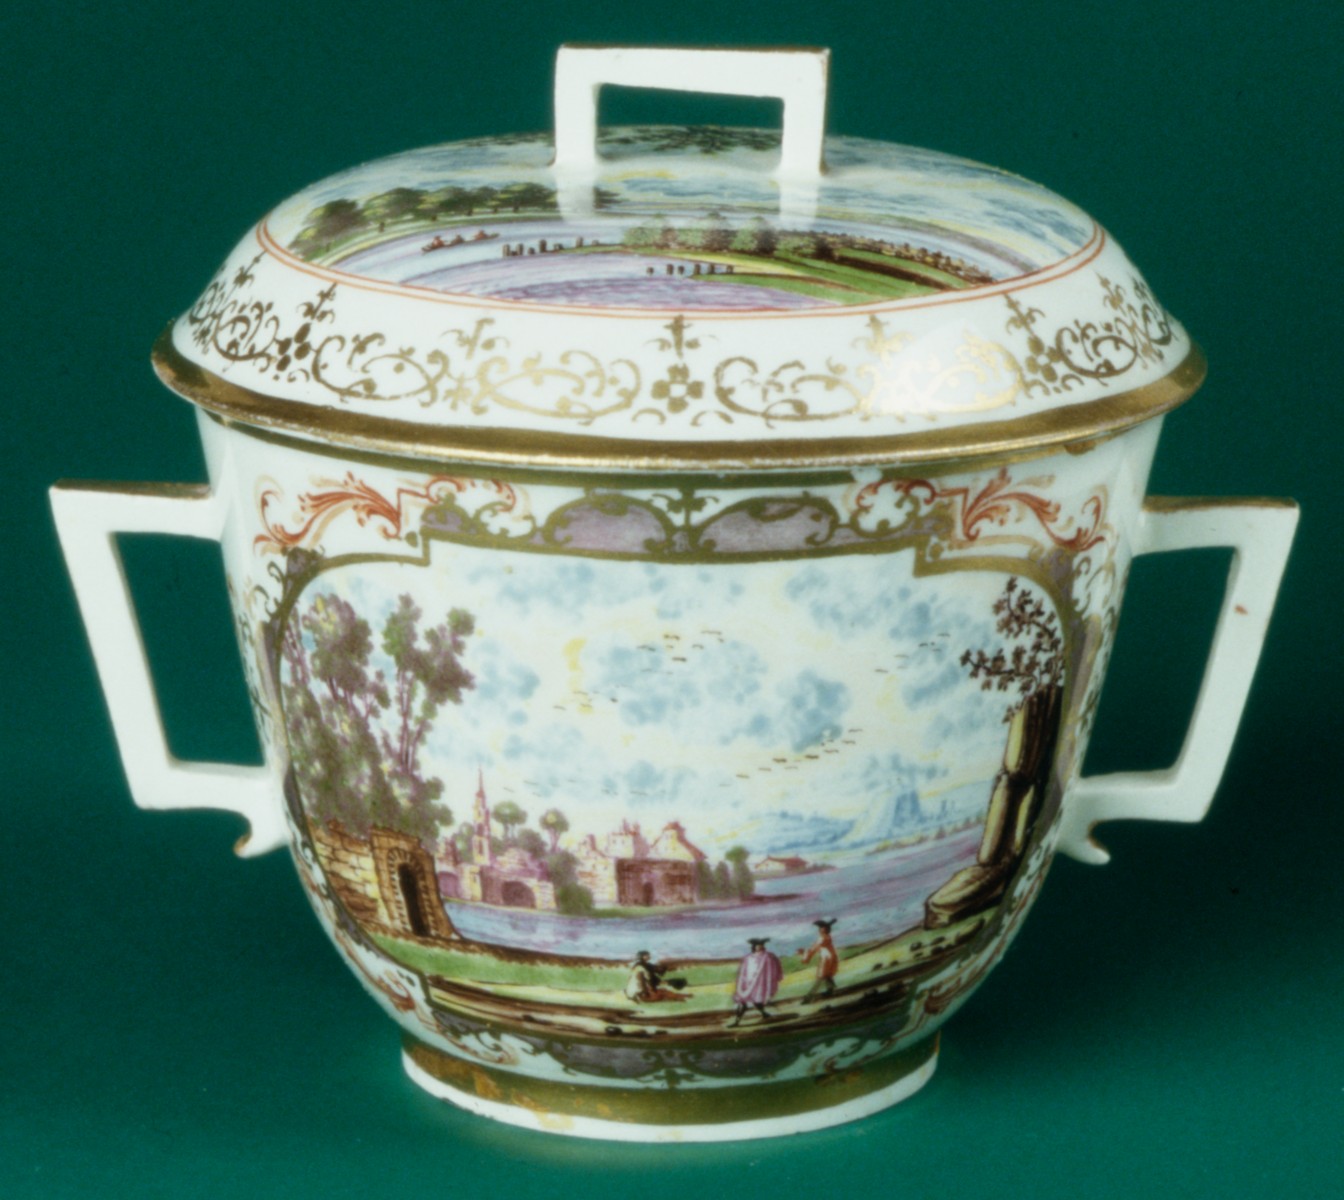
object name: bowl with cover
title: Bowl with cover (part of a set)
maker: meissen manufactory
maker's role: manufactory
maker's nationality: german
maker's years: 1710-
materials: hard paste porcelain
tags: human figures,houses,landscapes,trees